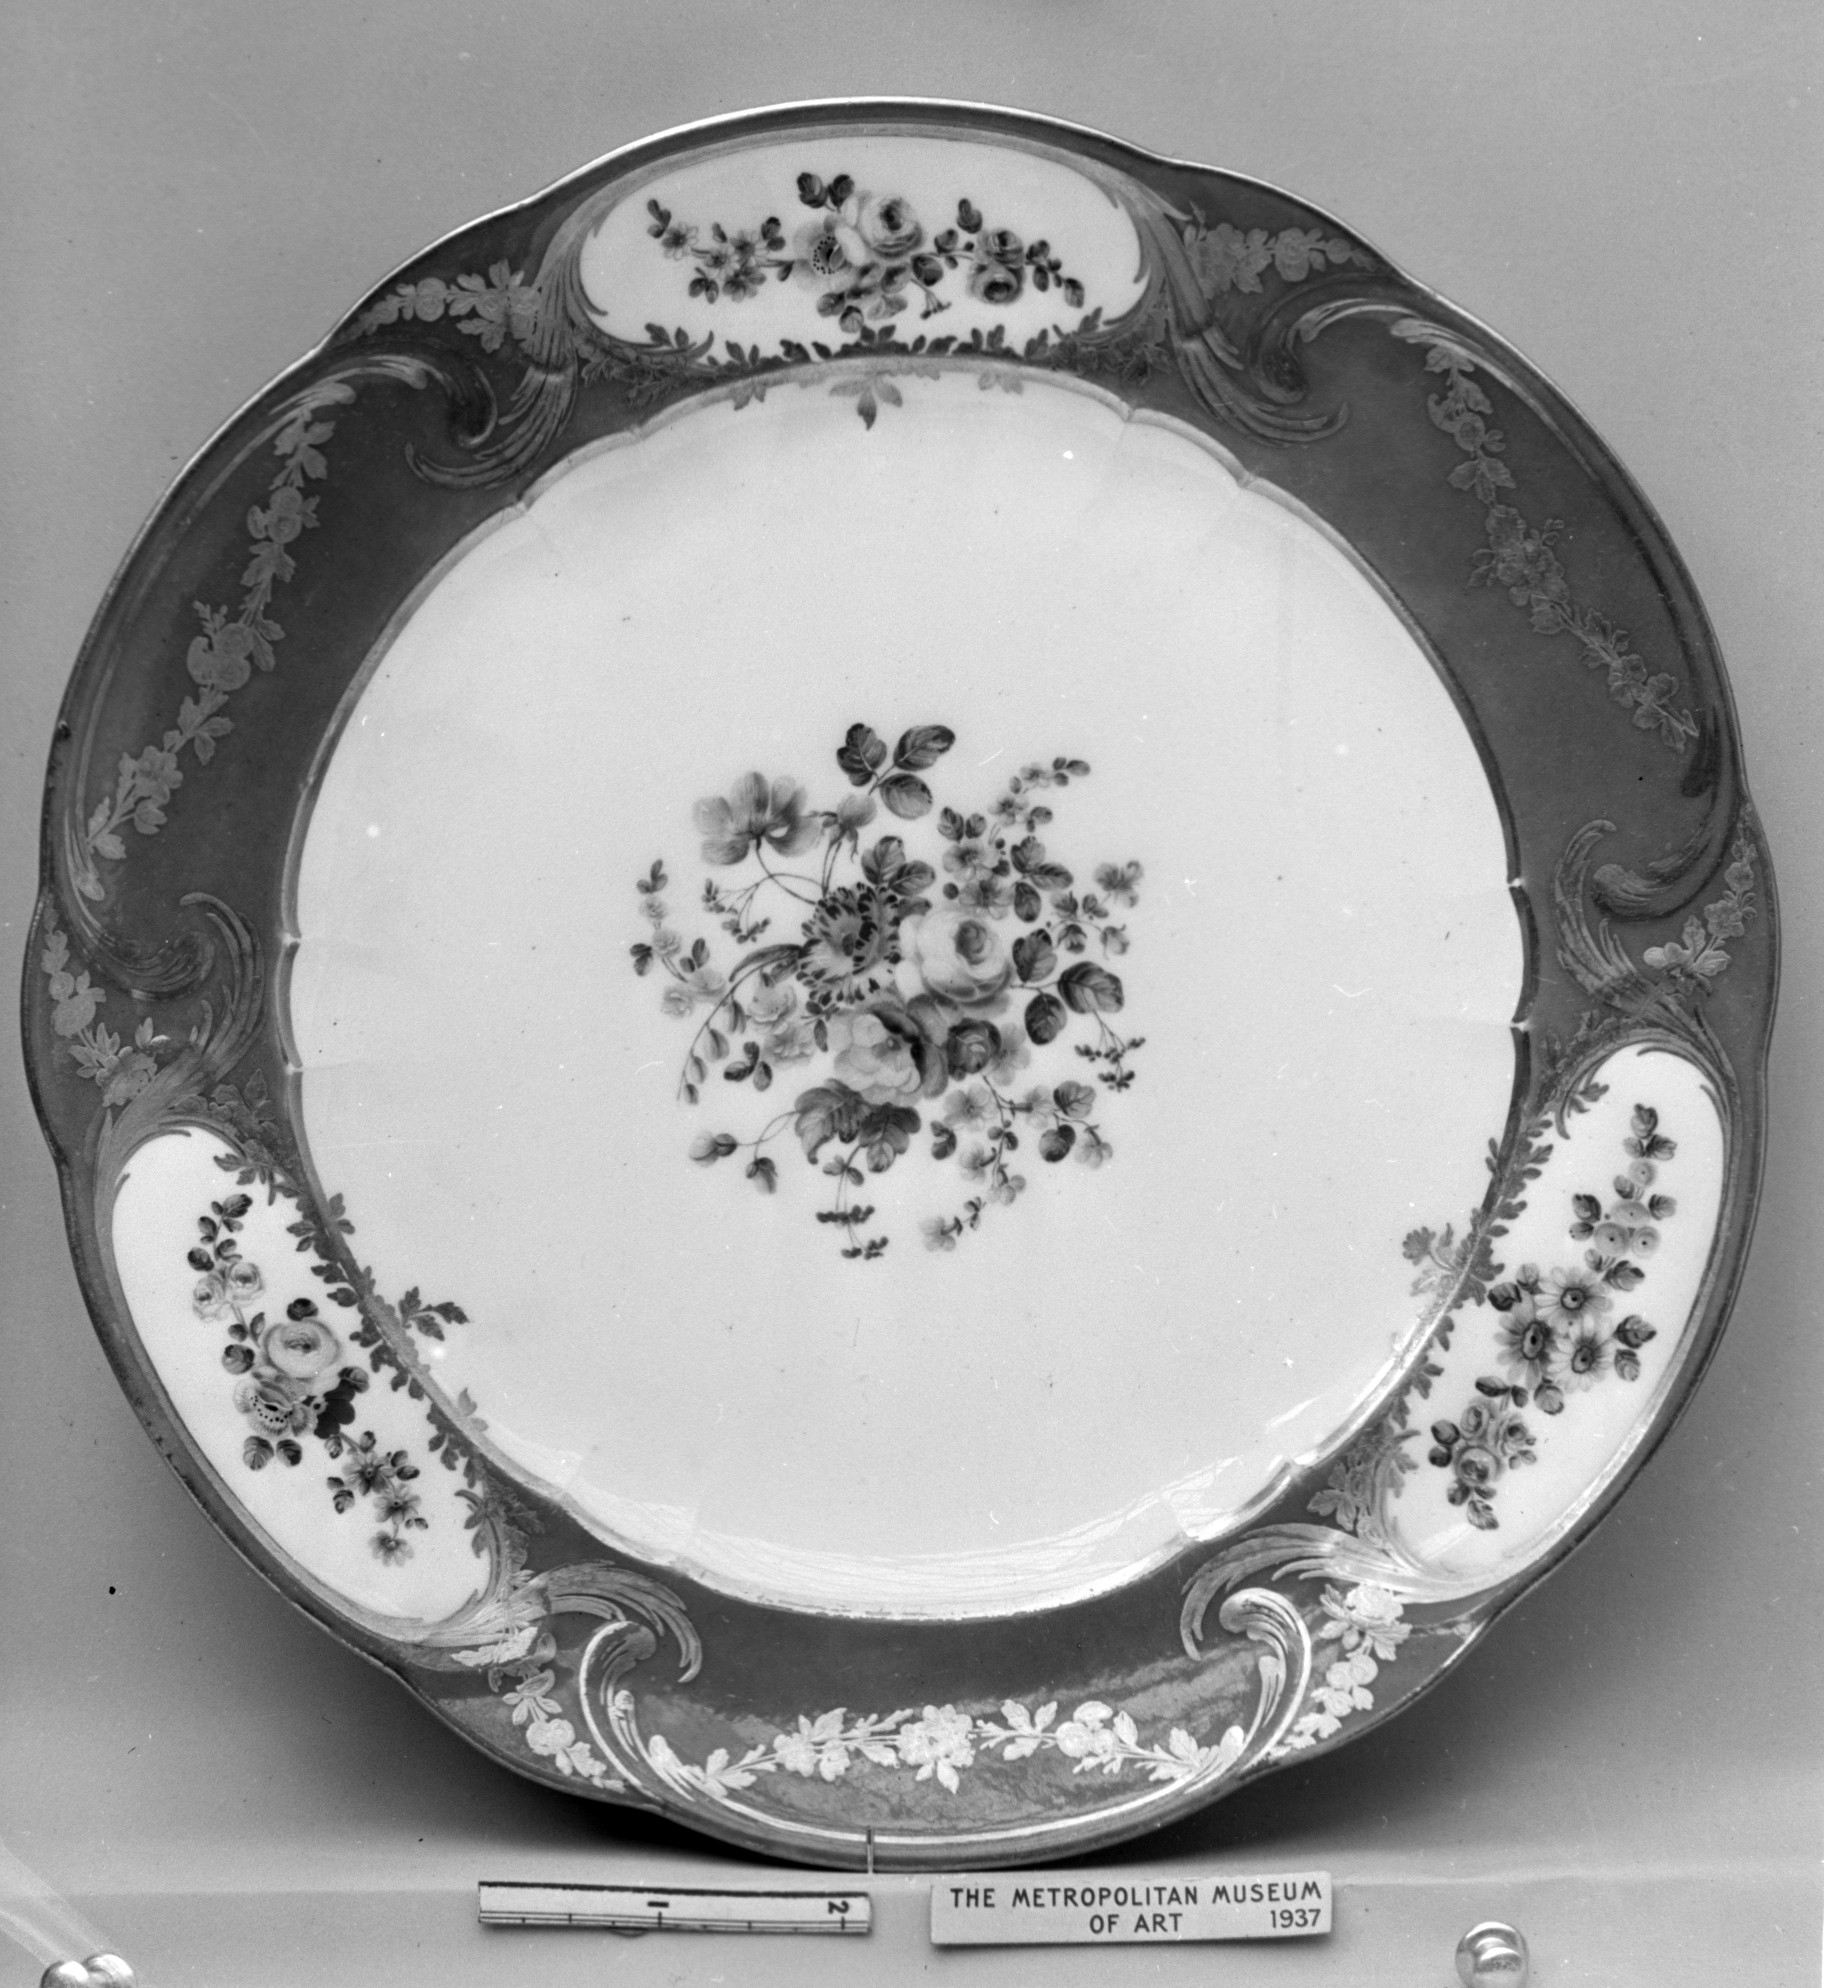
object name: plate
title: Plate (Assiette à palmes) (1 of 102) (part of a service)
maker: sèvres manufactory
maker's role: manufactory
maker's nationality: french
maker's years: 1740-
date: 1772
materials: soft paste porcelain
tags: roses